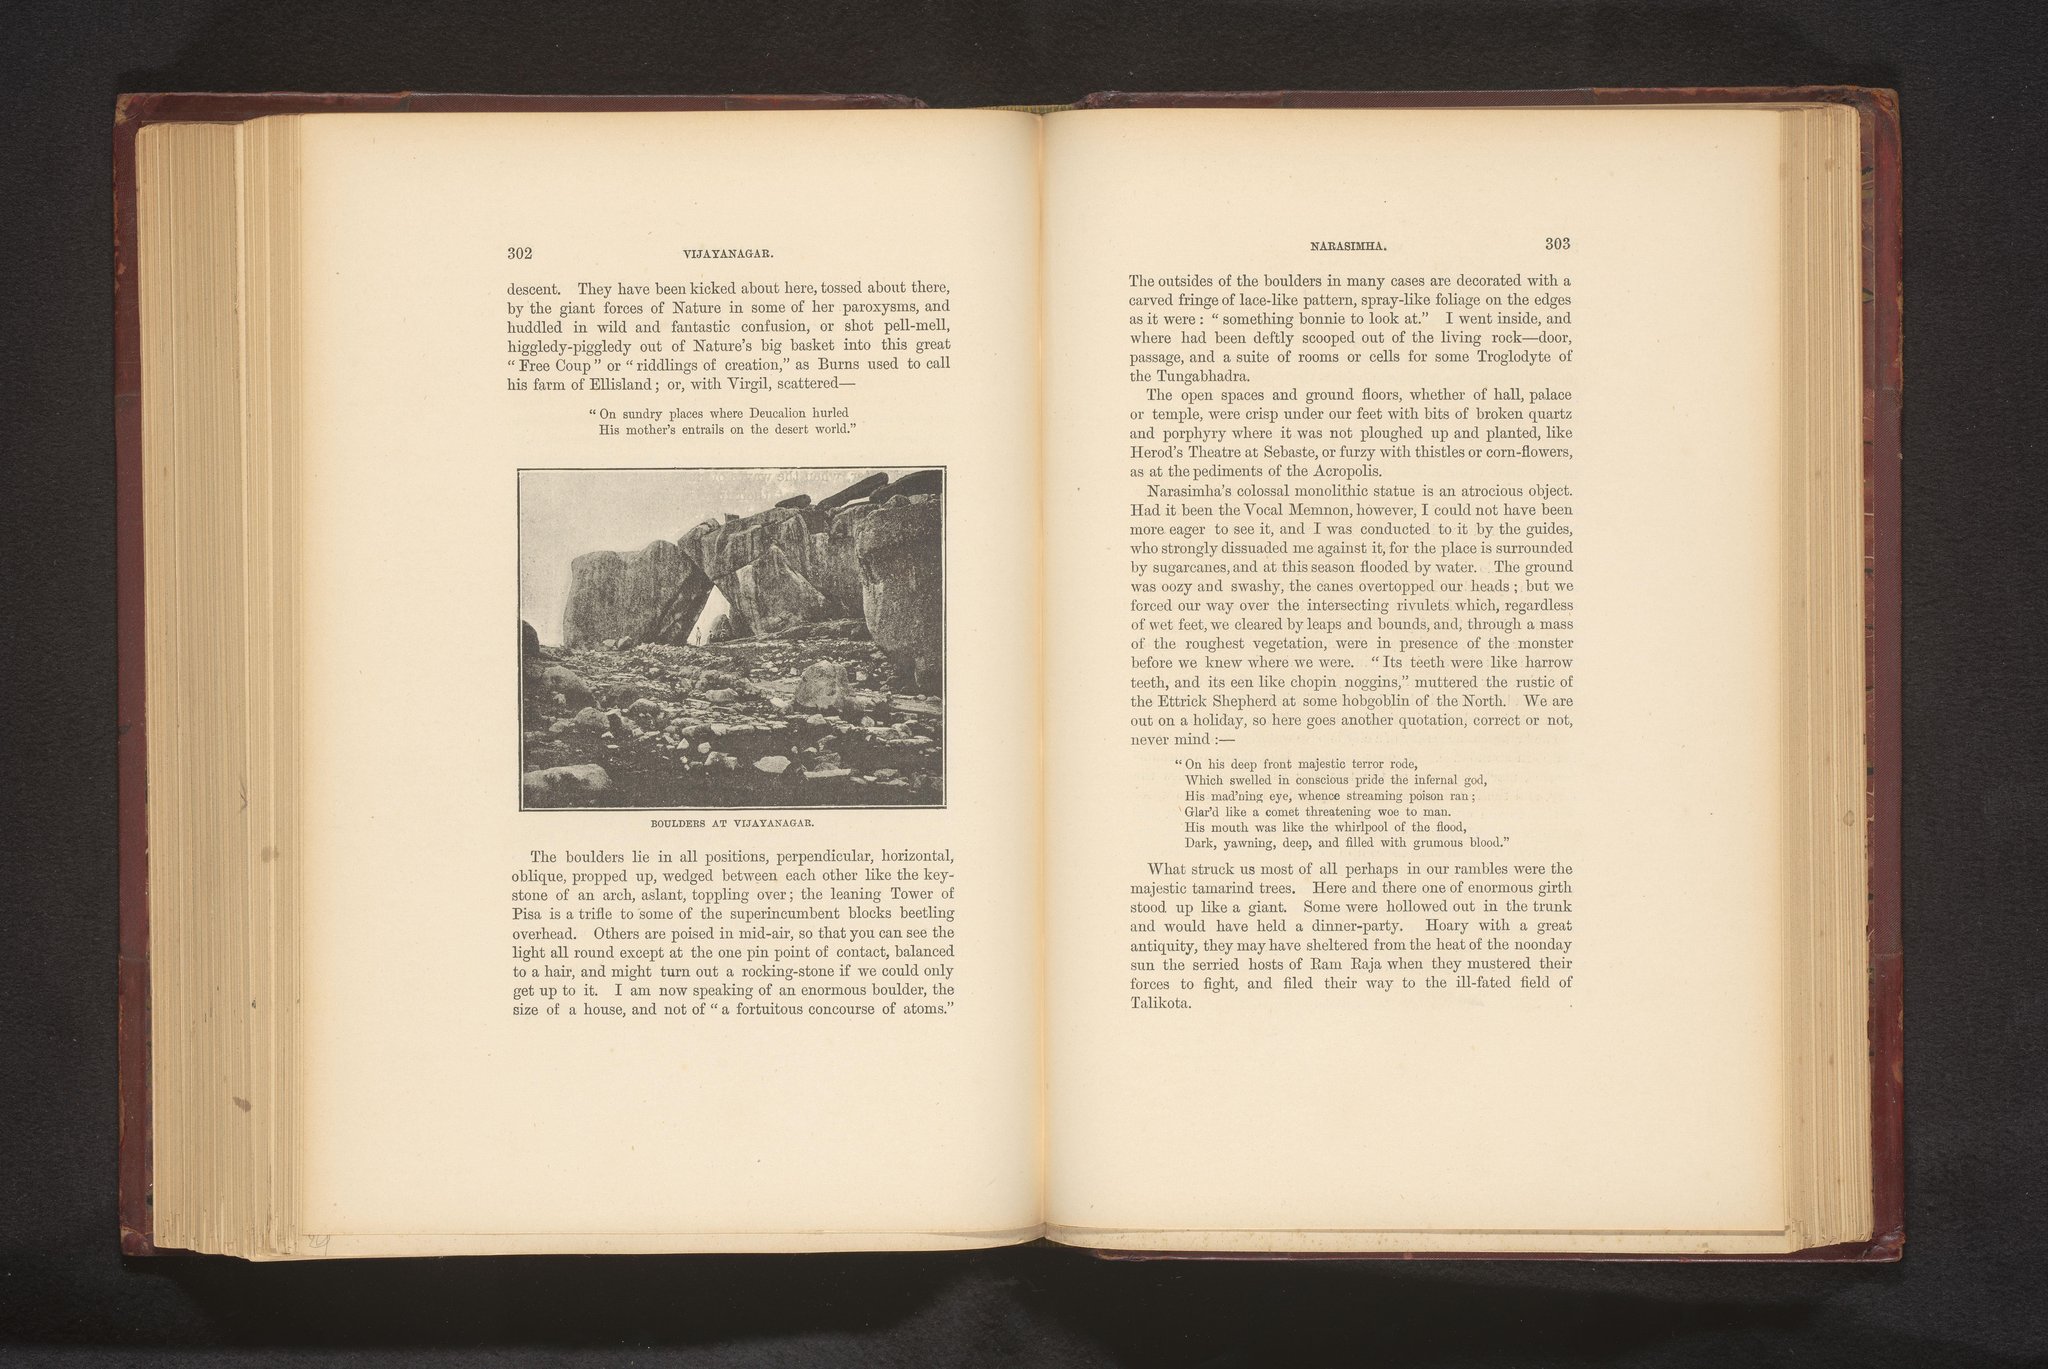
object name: photomechanical print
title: Boulders at Vijayanagar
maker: Anonymous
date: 1883-1893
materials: paper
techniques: autotype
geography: paris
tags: rock-formations